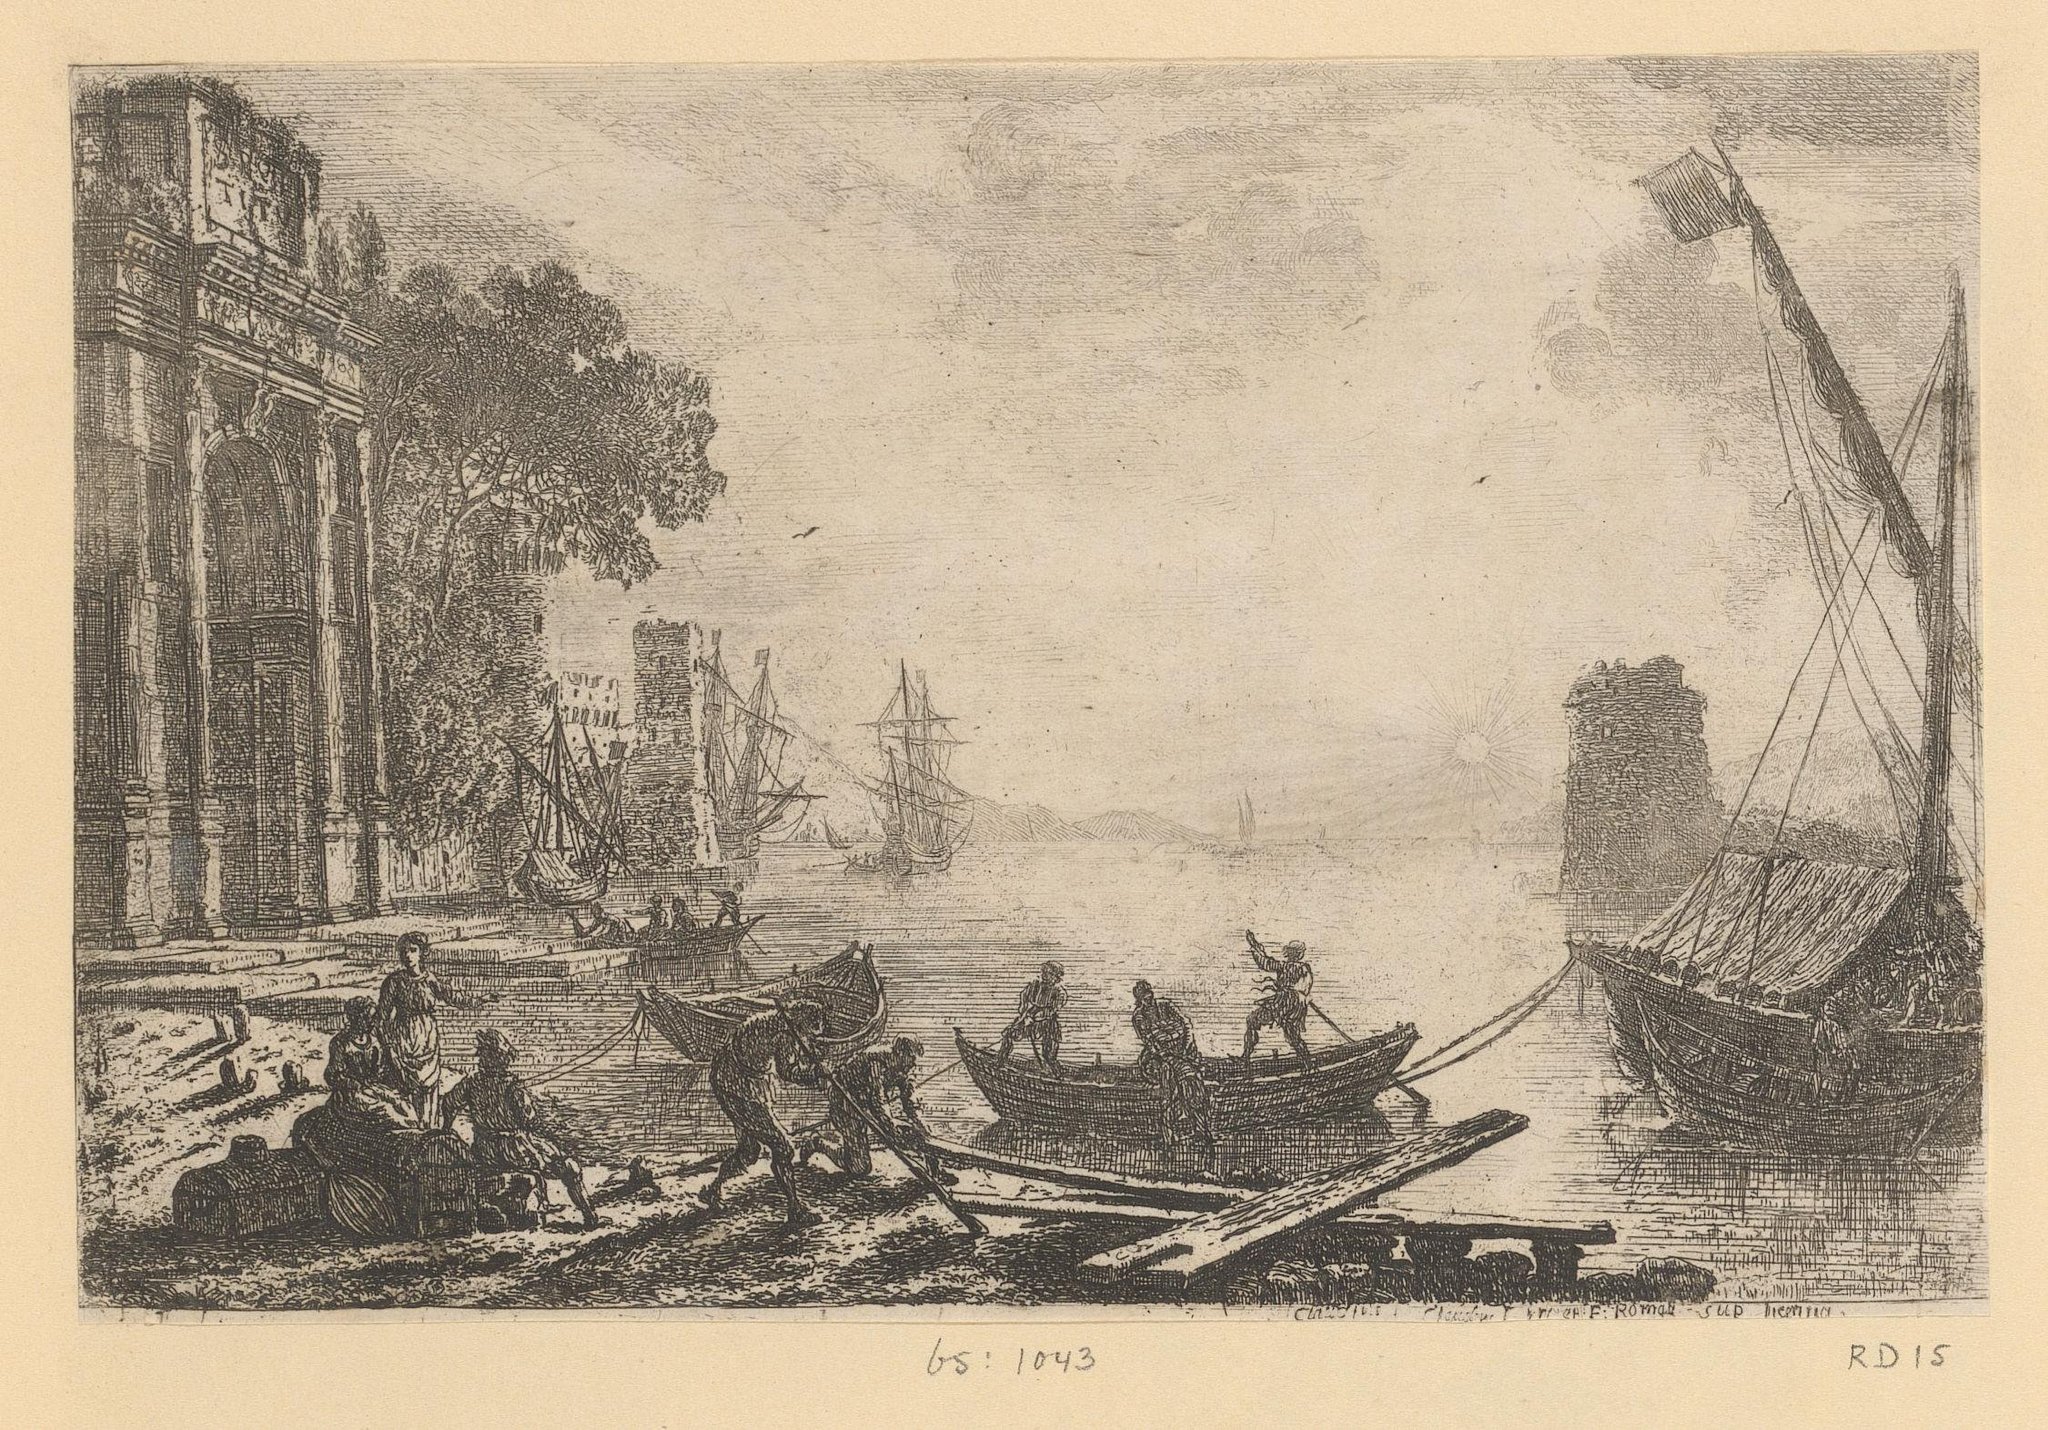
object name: album leaf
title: Haven met opgaande zon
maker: claude lorrain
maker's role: draughtsman, print maker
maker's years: 1604-1682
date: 1634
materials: paper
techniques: etching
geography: rome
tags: harbour, sunrise, 'en route', traveller under way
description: Prent maakt mogelijk deel uit van een serie van 200 prenten. Deze serie is onder de titel 'A Collection of two hundred original etchings' voor het eerst uitgegeven door J.M. Greery in 1816.